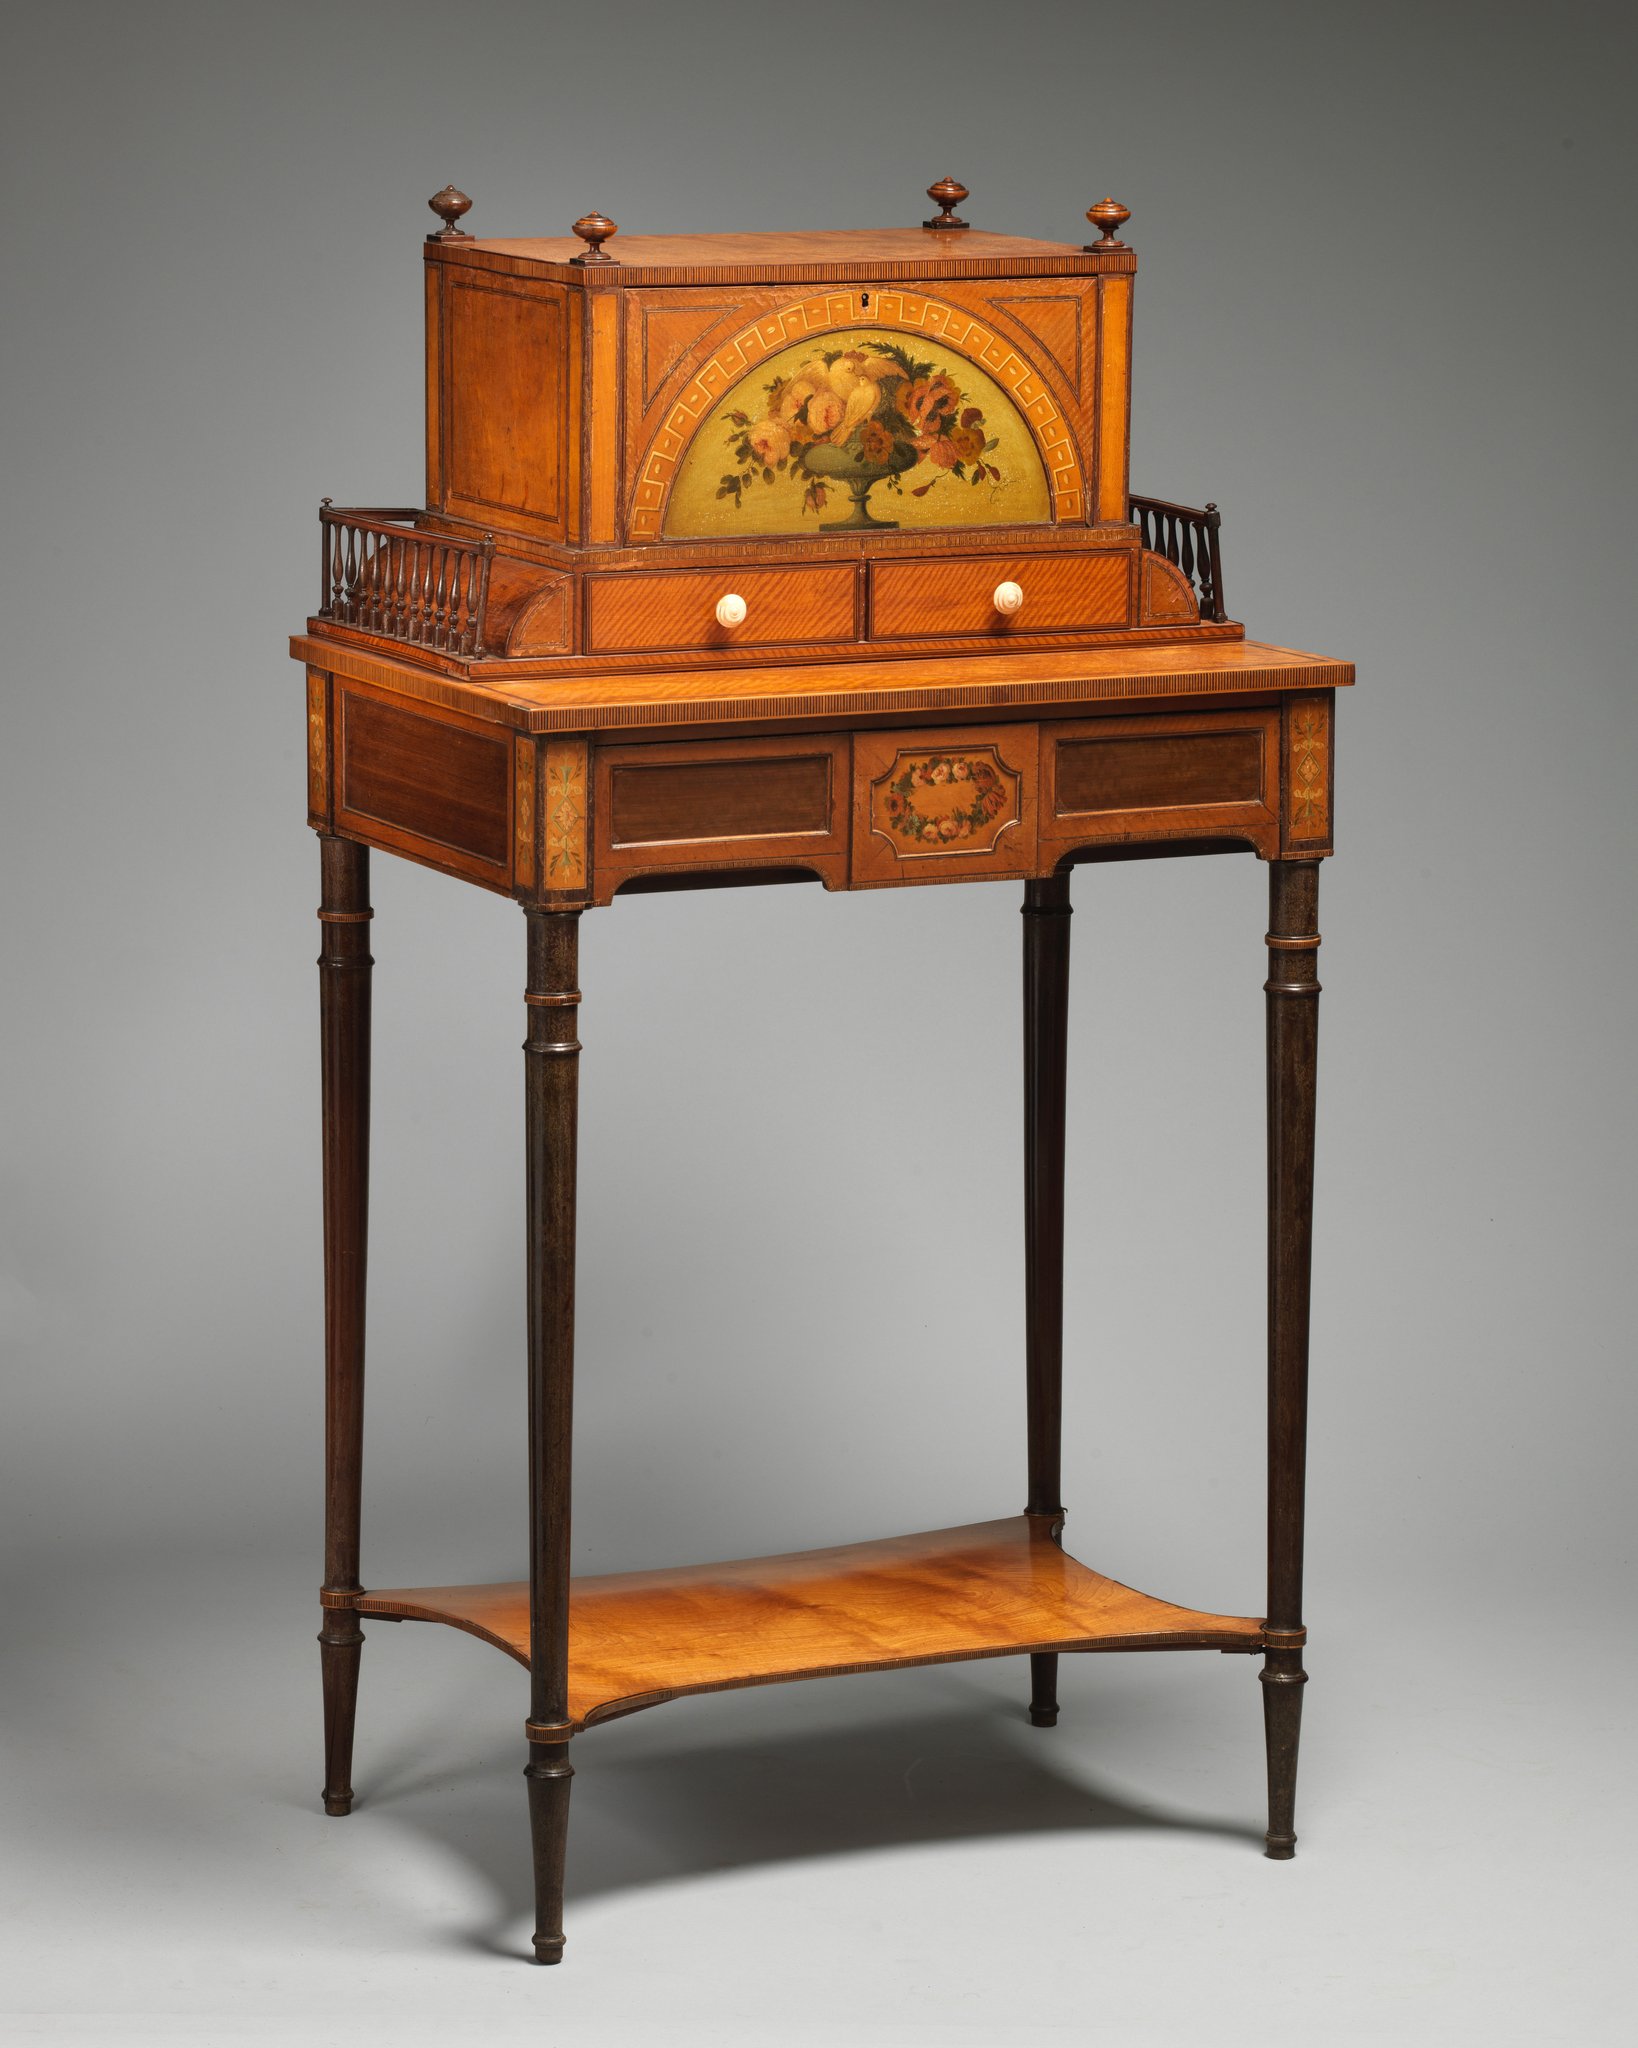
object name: writing cabinet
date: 1790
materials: wood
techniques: inlay, painting, veneering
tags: birds,flowers